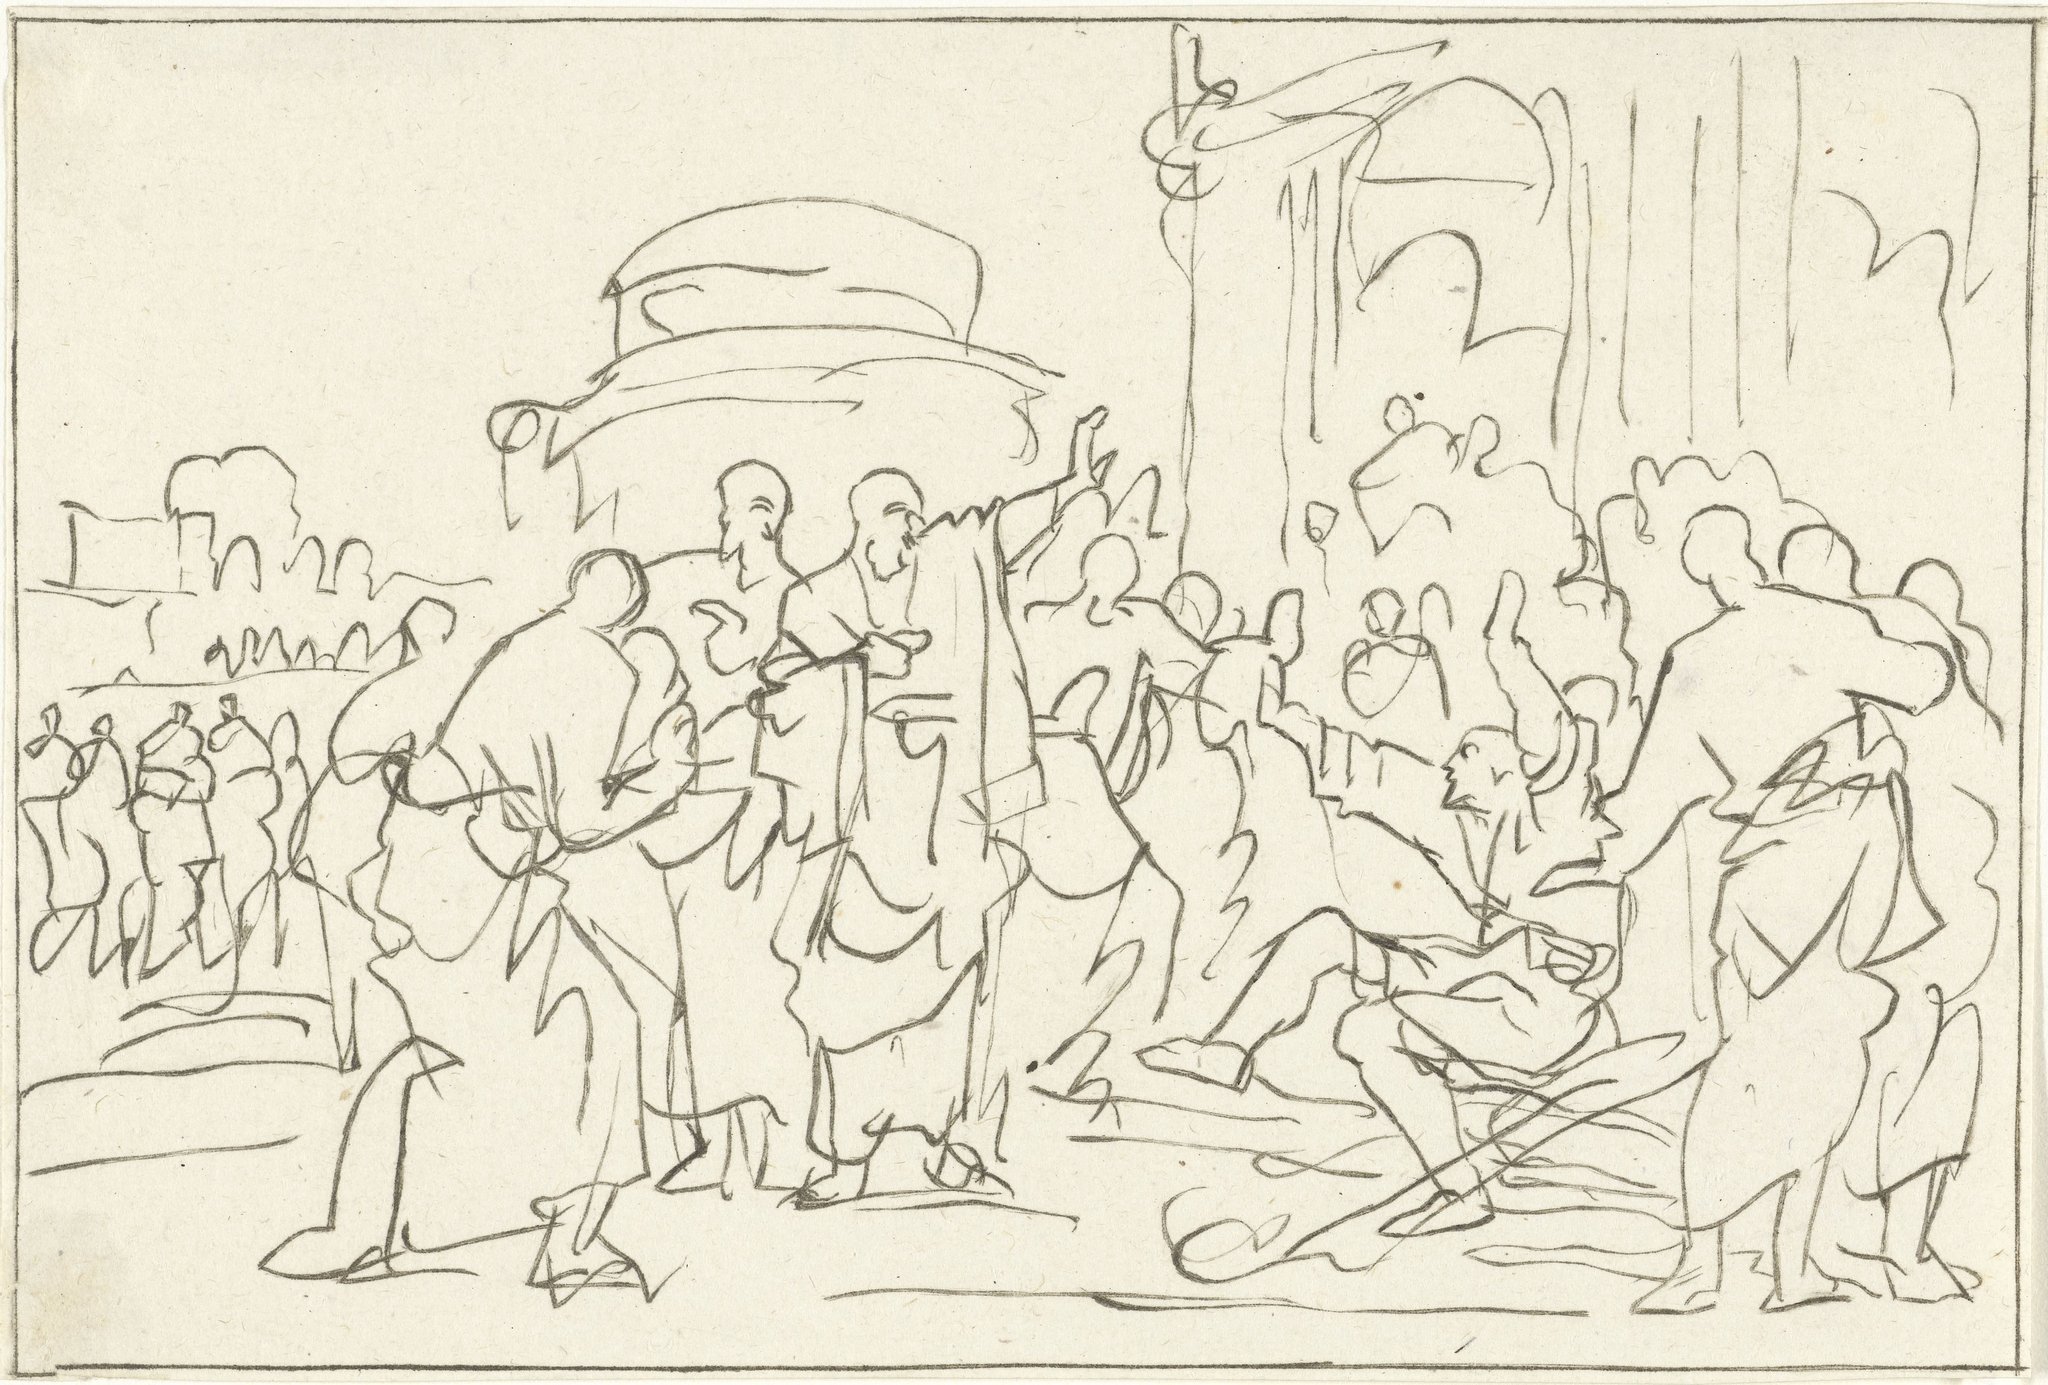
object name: print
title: Peter and John heal a paralyzed man at the temple gate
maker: benjamin martini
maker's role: print maker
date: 1777-1780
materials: paper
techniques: etching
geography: amsterdam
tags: healing of a lame beggar at the beautiful gate of the temple by peter and john (acts 3 - 4:31), disabilities, deformations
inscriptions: collector's mark: Lugt 240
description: De voorstelling is gebaseerd op de tekst uit Handelingen 3:4-31. In de Statenvertaling is de bedelaar beschreven als: “En een zeker man, die kreupel was van zijner moeders lijf, werd gedragen, welken zij dagelijks zetten aan de deur des tempels (…) Maar Petrus zei (…) In den Naam van Jezus Christus den Nazaréner, sta op en wandel. En hem grijpende bij de rechterhand, richtte hij hem op, en terstond werden zijn voeten en enkels vast”. In de Nieuwe Bijbelvertaling wordt er niet gesproken over ‘kreupel’ maar over verlamming: “Men had ook een man die al sinds zijn geboorte verlamd was naar de tempel gebracht (…) Maar Petrus zei (…) in de naam van Jezus Christus van Nazareth, sta op en loop.’ Hij pakte hem bij zijn rechterhand om hem overeind te helpen. Onmiddellijk kwam er kracht in zijn voeten en enkels.”